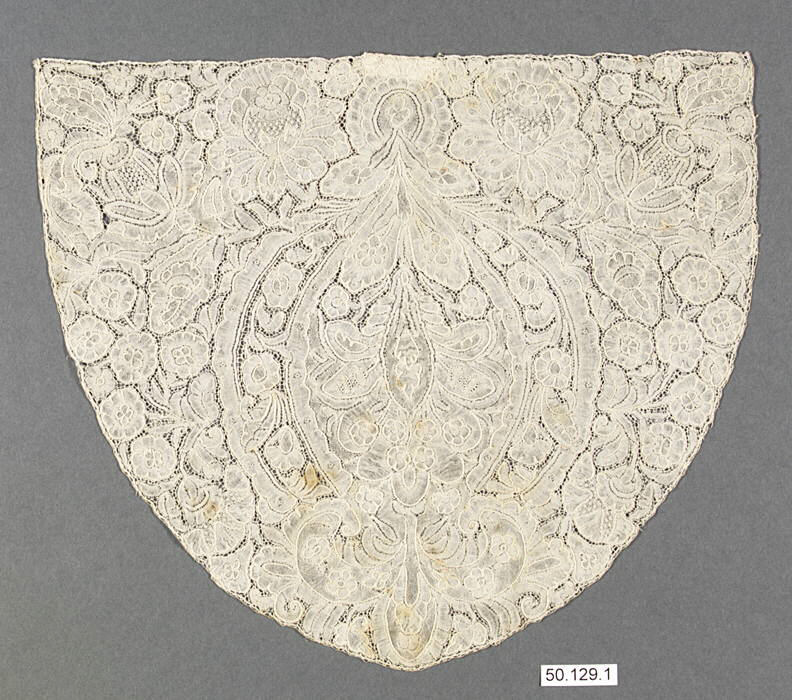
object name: cap crown and lappet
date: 1701-1750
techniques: lace